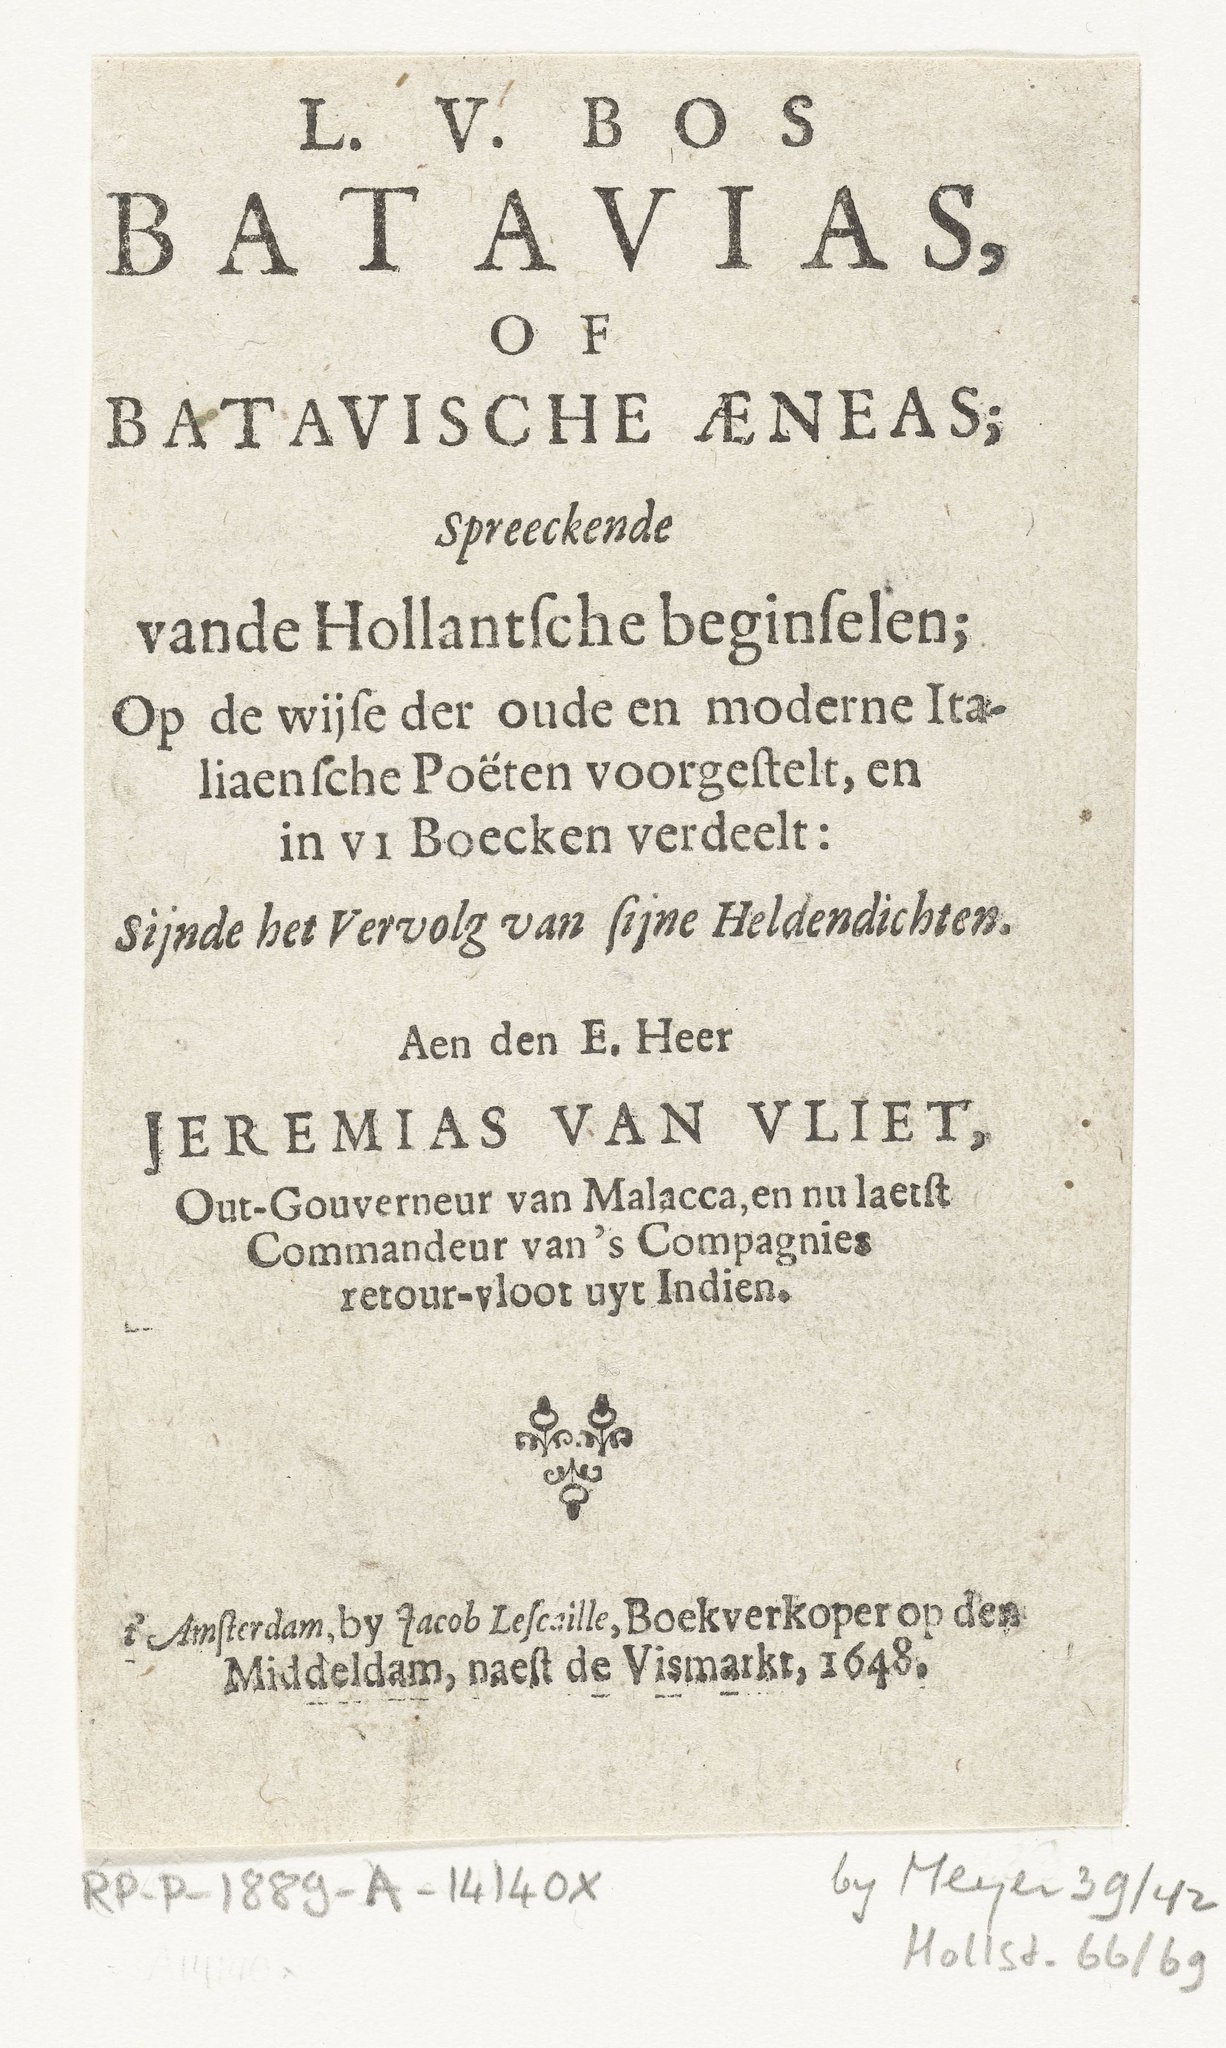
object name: titelblad, titelpagina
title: Titelpagina voor: L.V. Bos, Batavias, of Batavische Aeneas, Amsterdam, 1648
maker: jacob lescaille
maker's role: publisher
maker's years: 1611-1679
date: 1648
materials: paper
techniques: letterpress printing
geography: amsterdam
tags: title-page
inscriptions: collector's mark: Lugt 2228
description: Titelpagina uit: Lambert van den Bos, Batavias, of Batavische Aeneas, Amsterdam, Jacob Lescaille, 1648